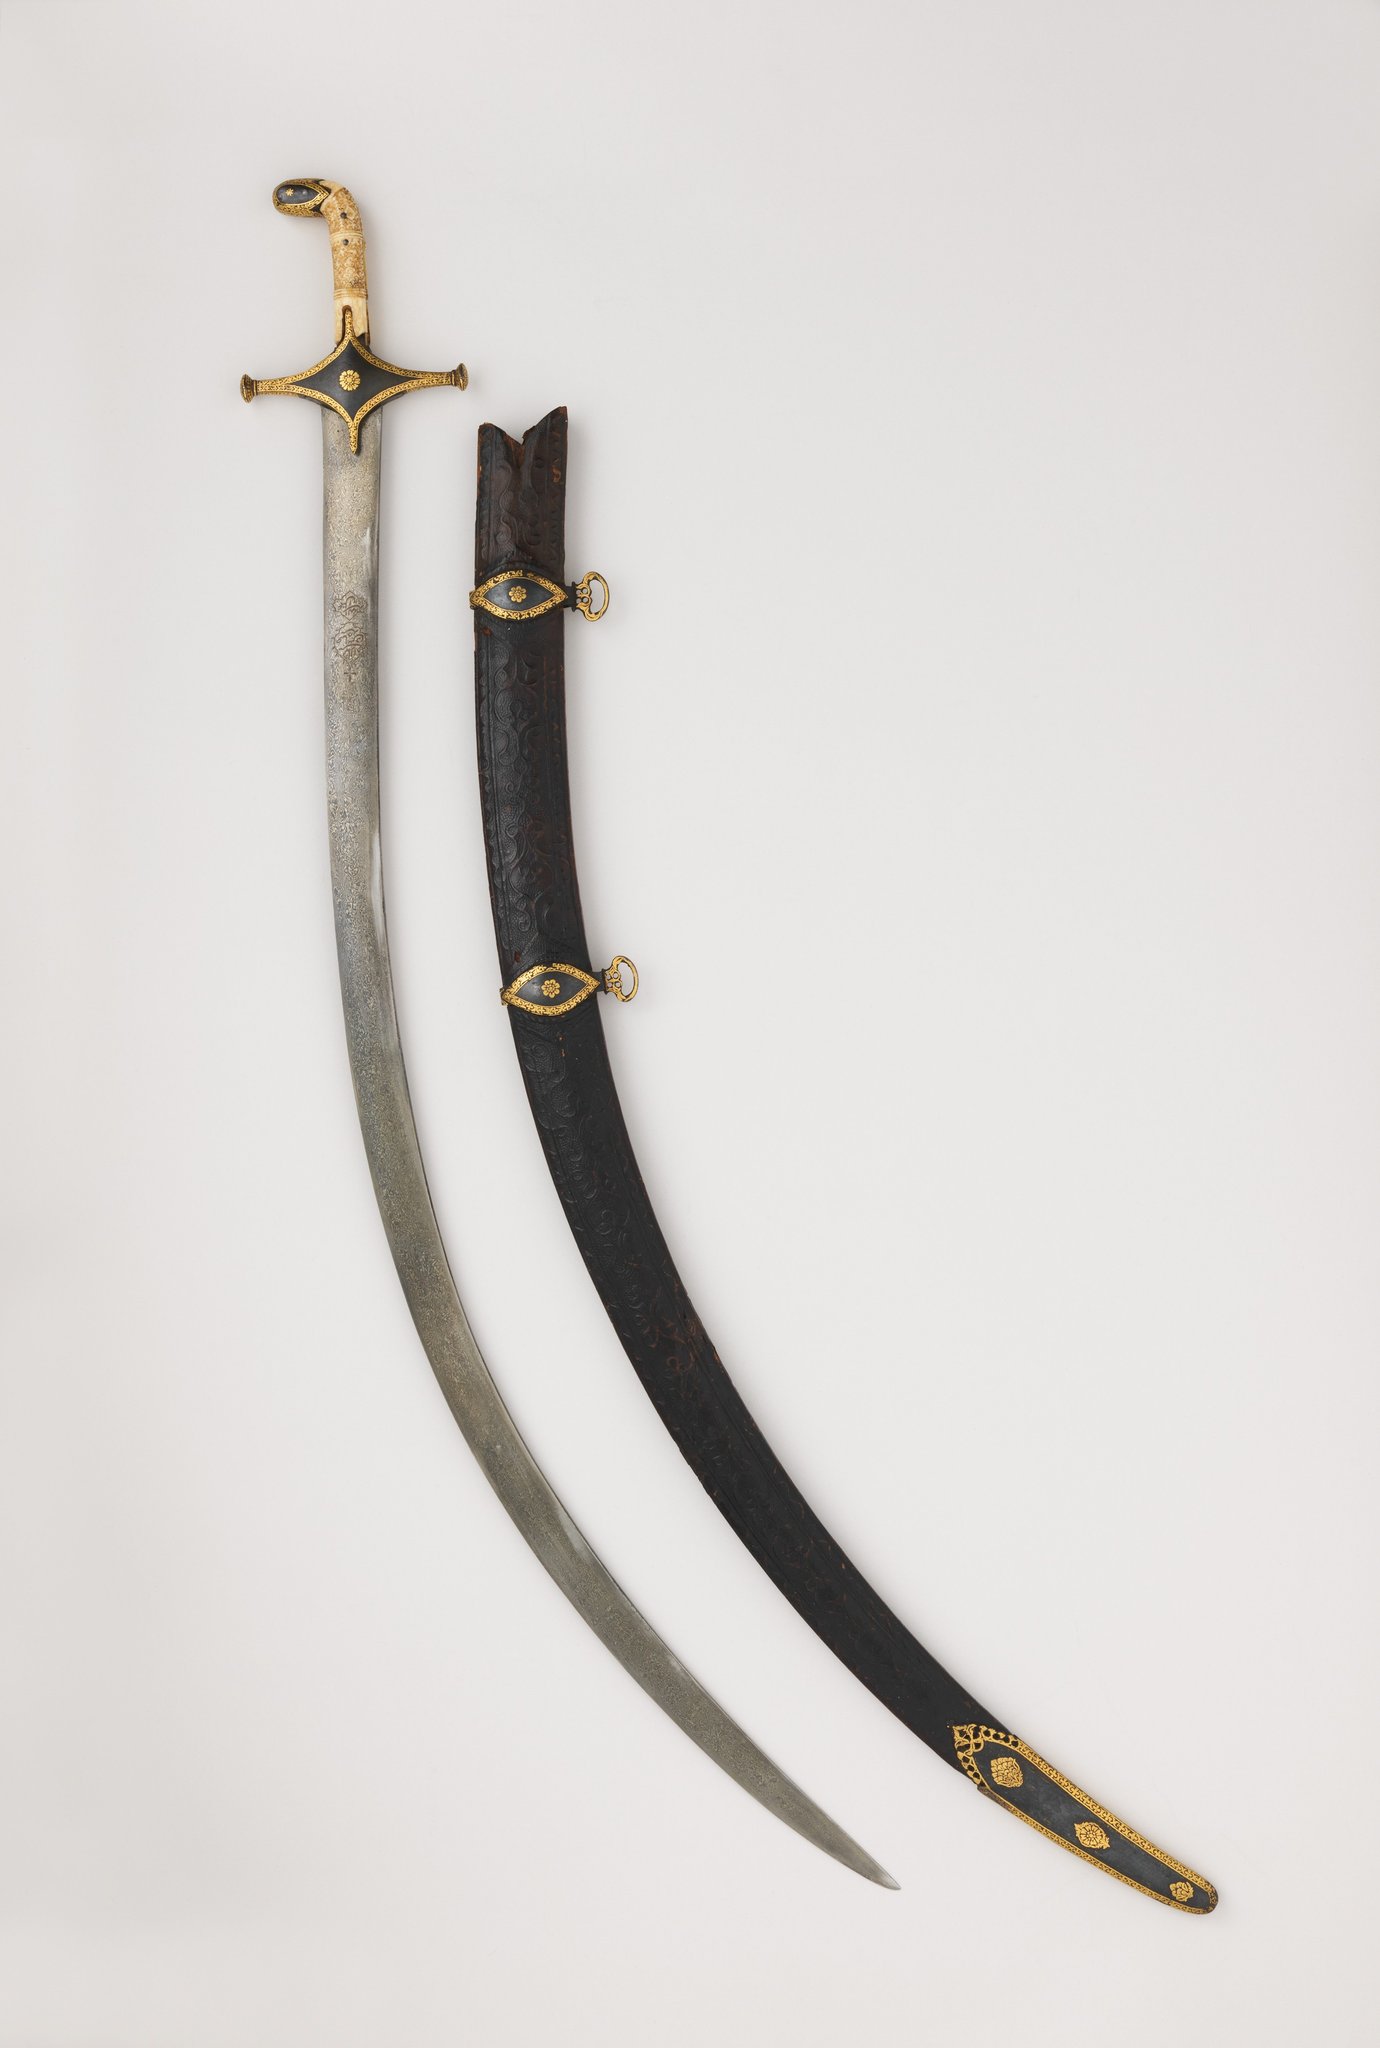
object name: saber with scabbard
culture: persian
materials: gold, ivory, leather, steel, wood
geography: iran